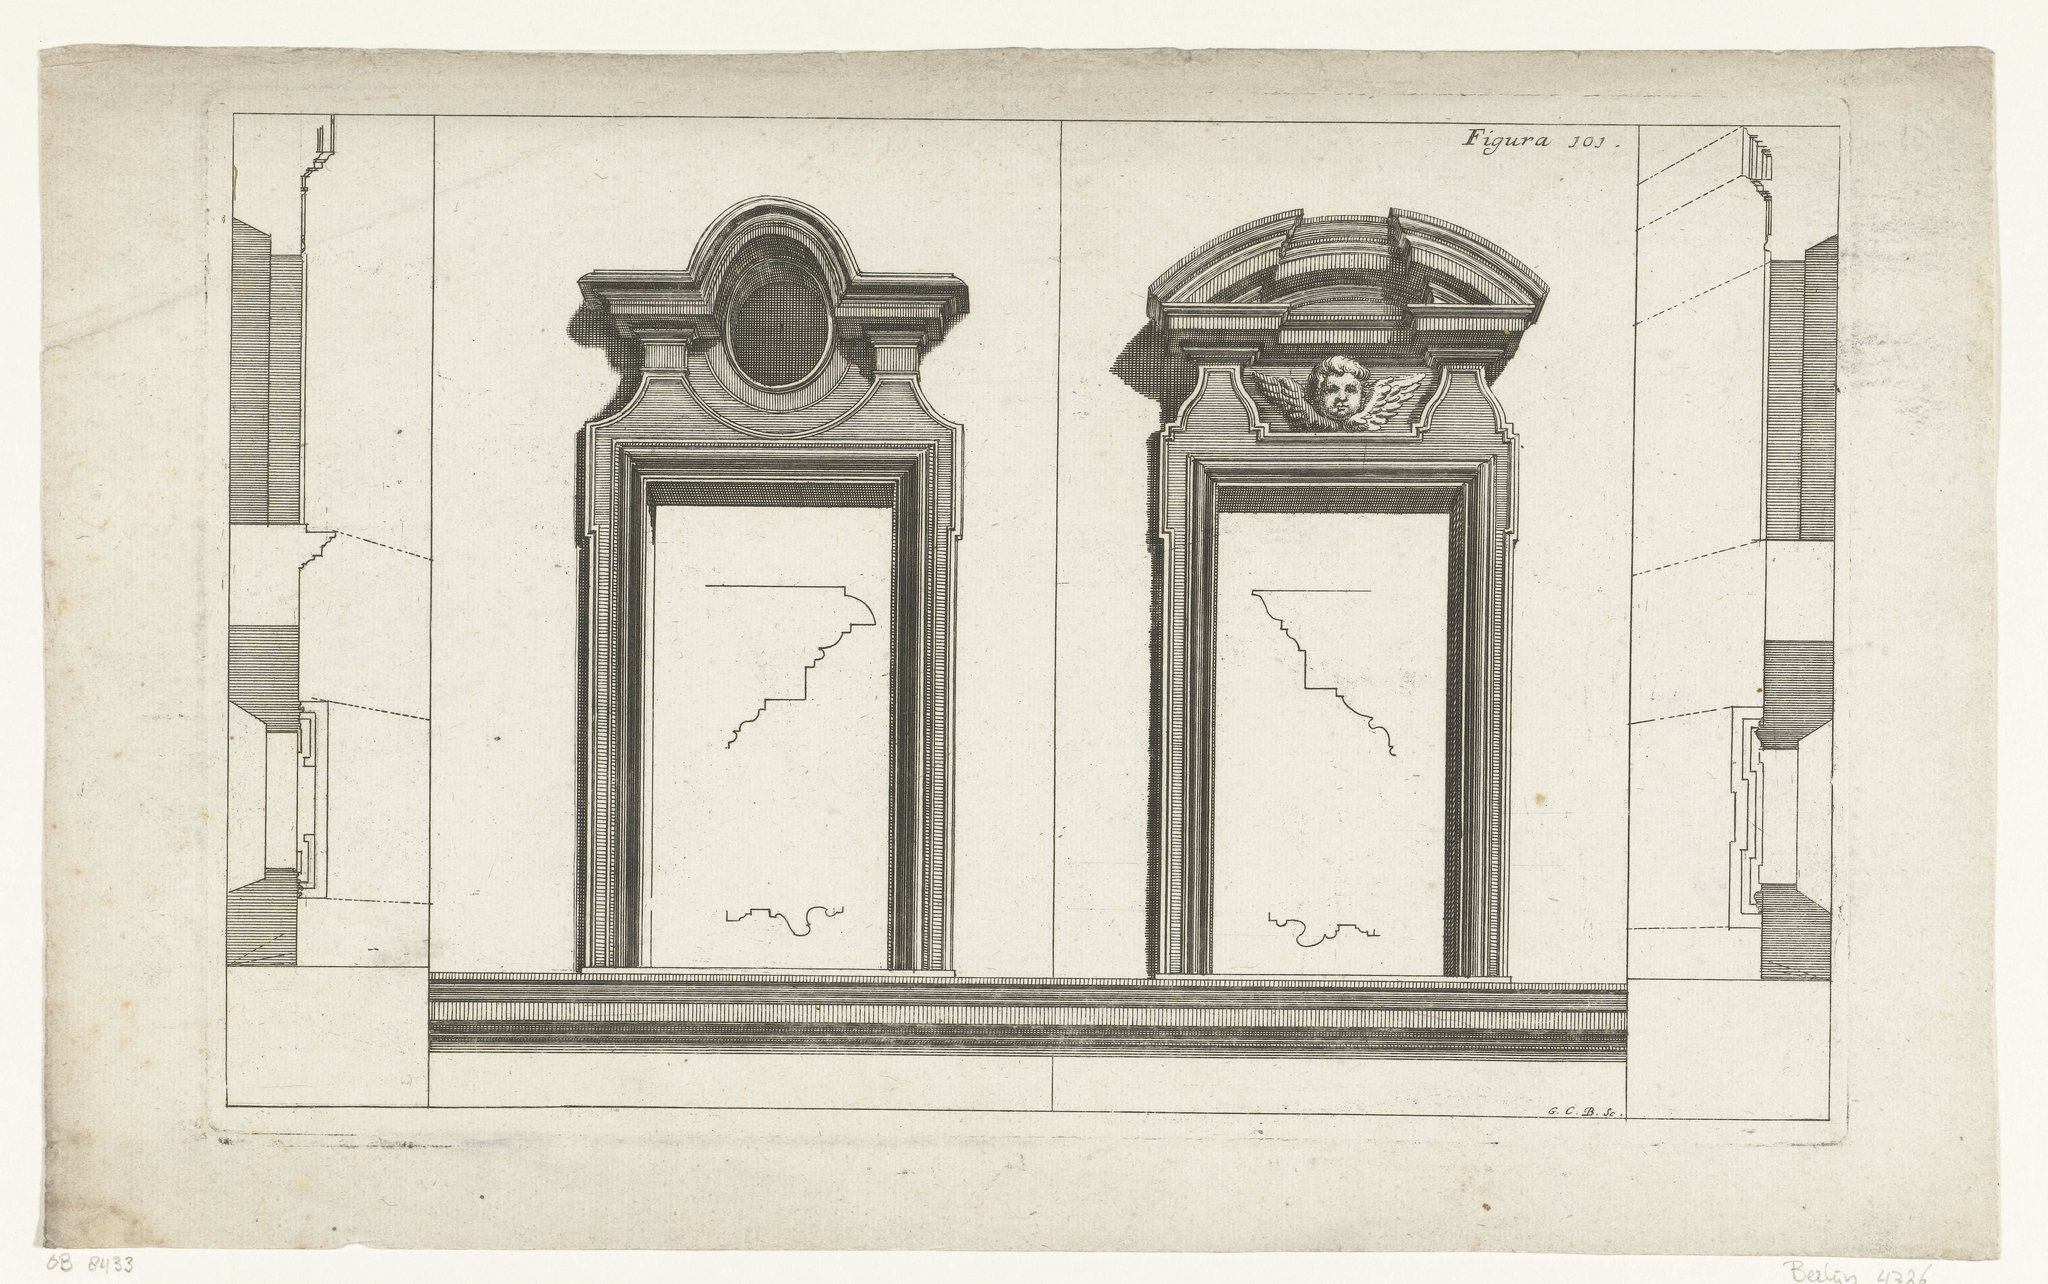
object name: ornament print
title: Twee raamkozijnen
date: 1708-1711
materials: paper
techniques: engraving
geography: augsburg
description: Raamkozijnen met opstand, plan, profiel en details. Rechtsboven staat: Figura 101. Uit deel II van de serie Perspectivae Pictorum atque Architectorum.